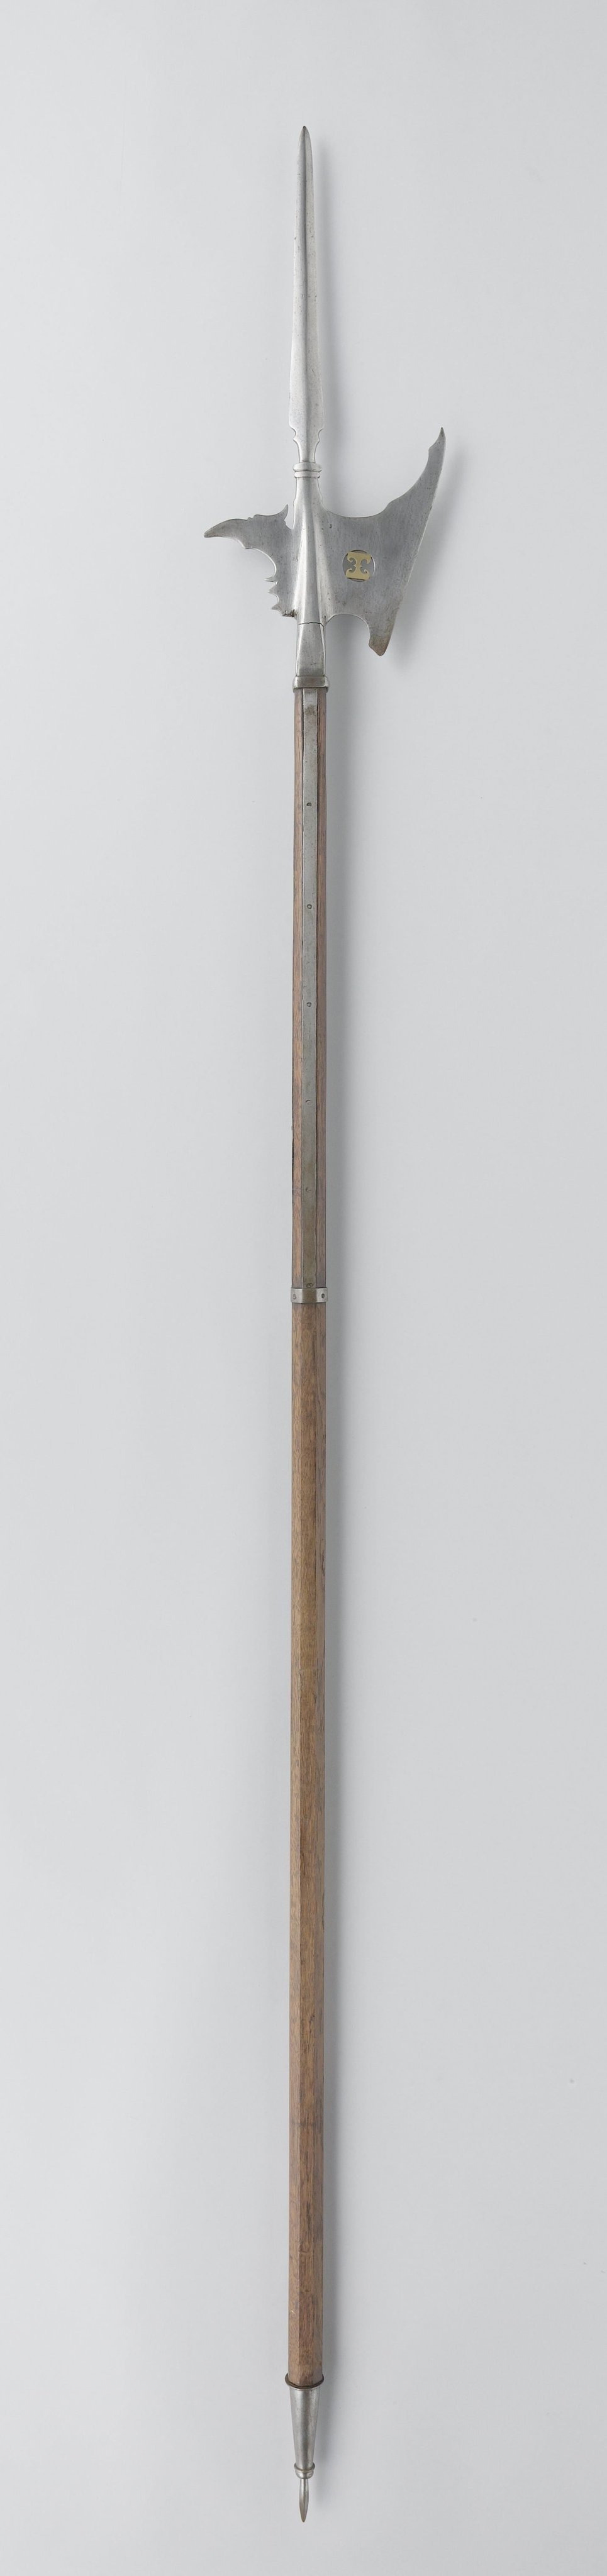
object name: halberd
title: Hellebaard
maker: Anonymous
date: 1600-1699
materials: copper, iron, wood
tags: utrecht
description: Hellebaard met achthoekige houten stok. De 4 lippen zijn aan de stok genageld. Aan het uiteinde van de lippen een eveneens aan de stok genagelde ijzeren ring. De bijl loopt van onderen naar boven breed uit. De achterkant ervan is puntvormig gebogen en heeft een viertal kleine uitsteeksels. Centraal in de bijl een ronde uitsparing met daarin een koperen vorm. De onderste punt van de bijl is afgebroken. De lanspunt is smal en spits.